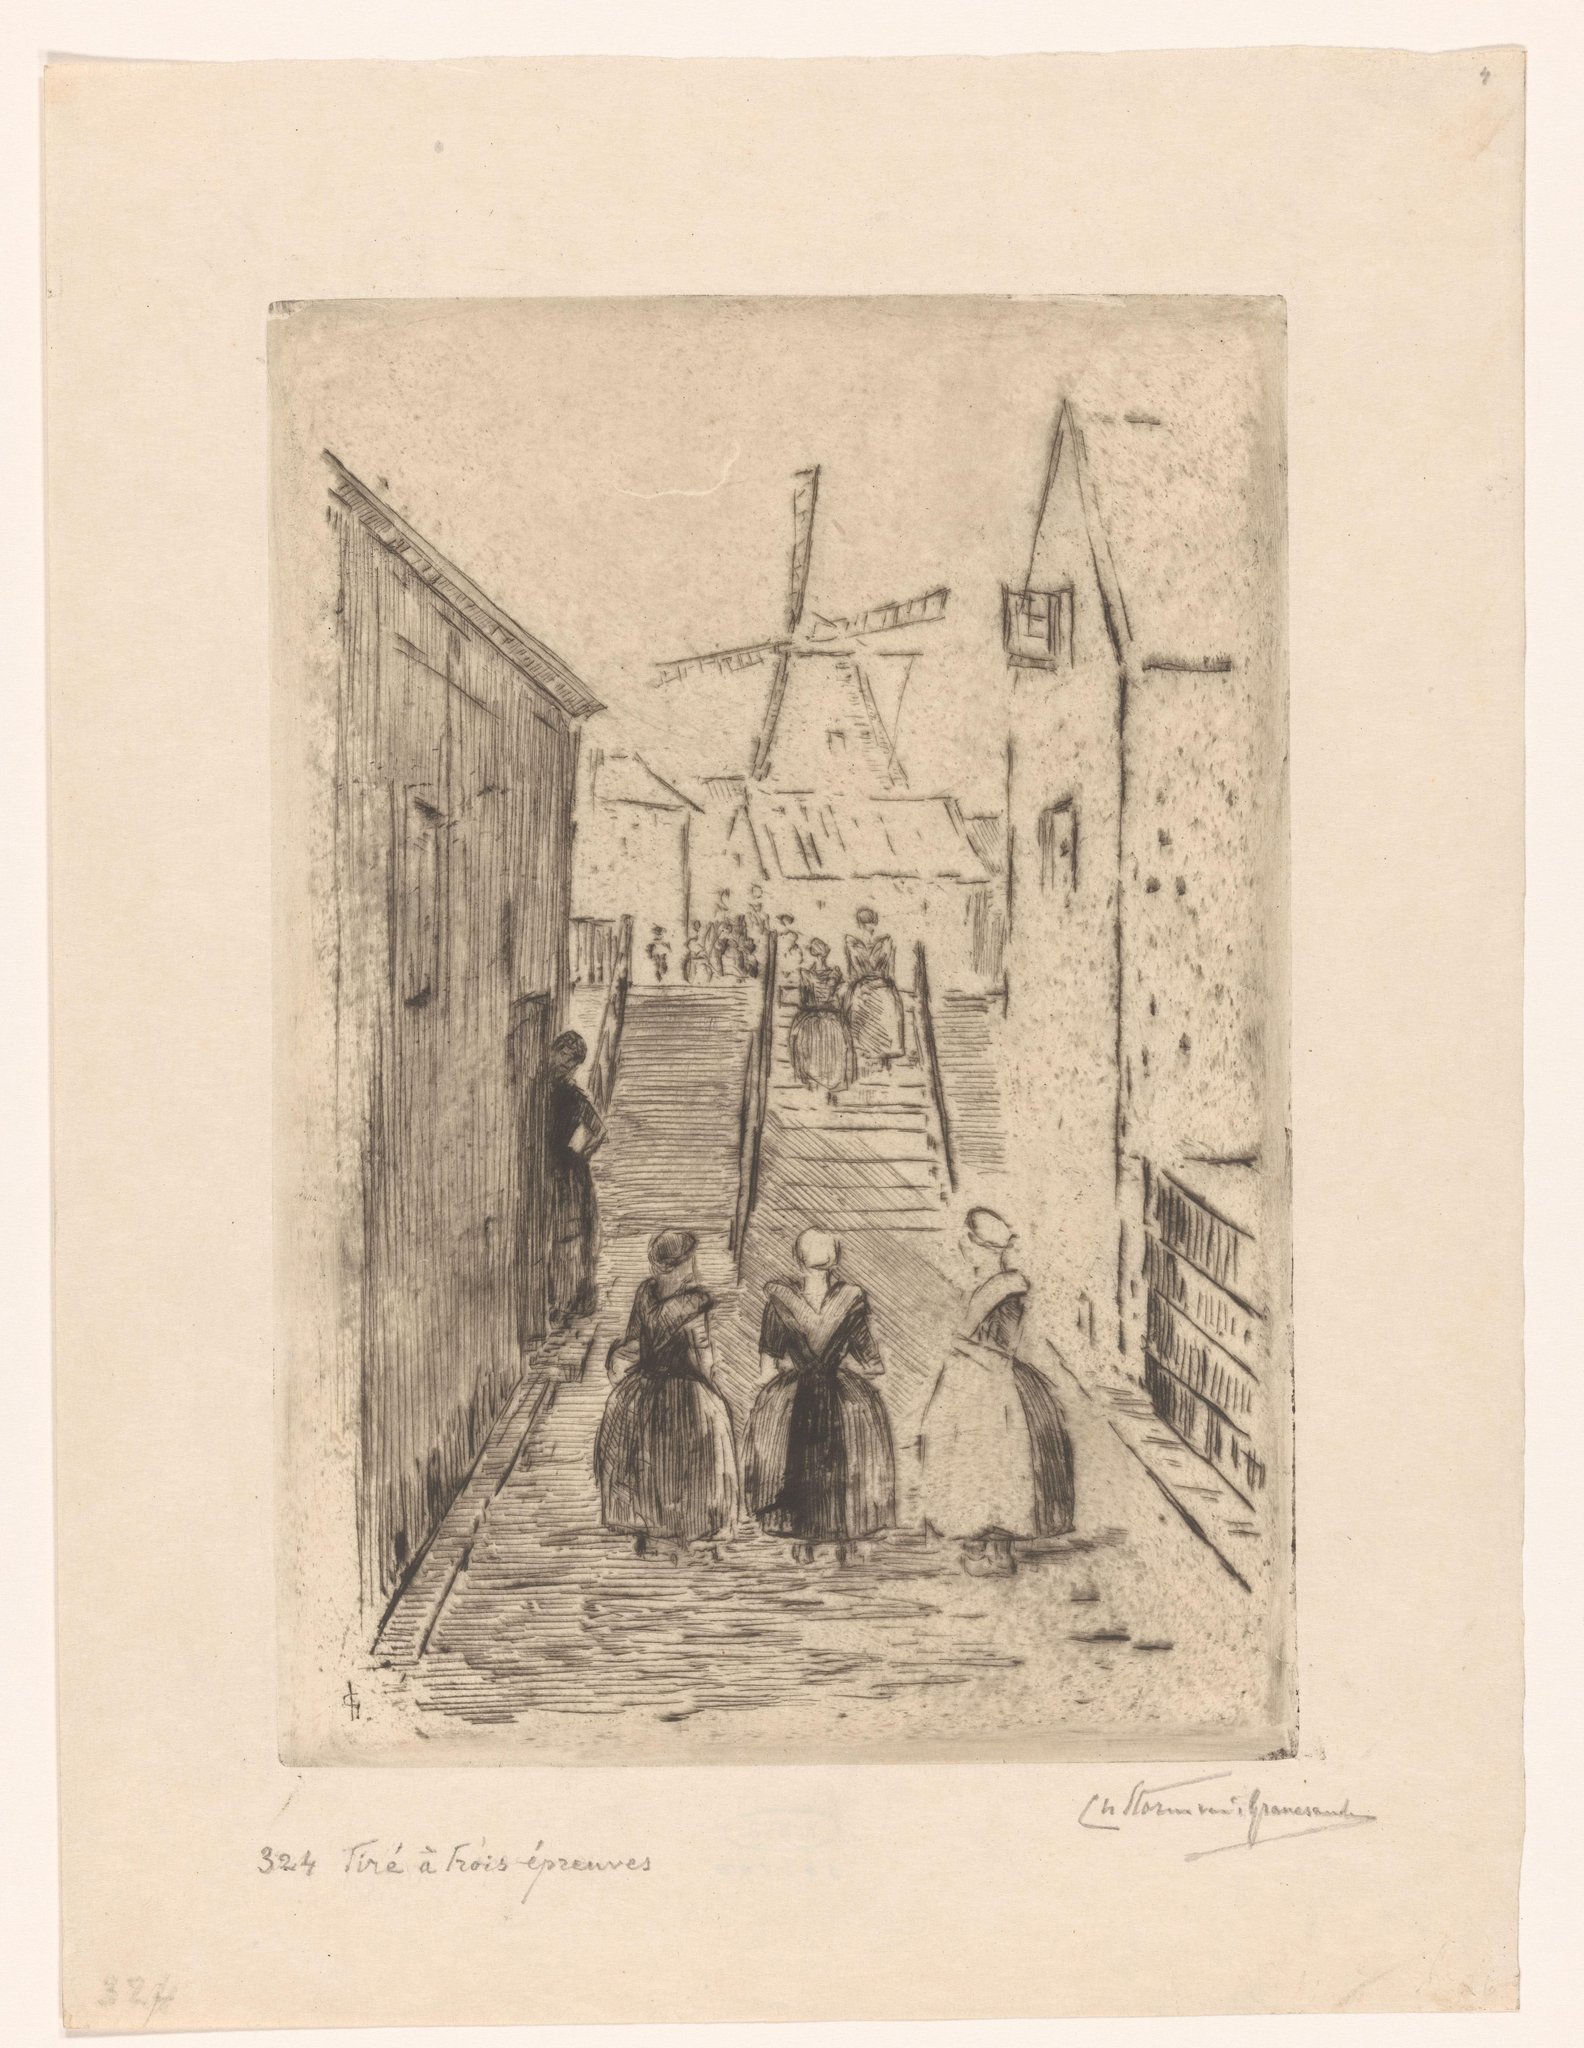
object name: print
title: Straatgezicht in Terneuzen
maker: carel nicolaas storm van s-gravesande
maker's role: draughtsman, print maker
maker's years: 1841-1924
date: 1889-1902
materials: paper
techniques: drypoint, intaglio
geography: netherlands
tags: sloping street; street with steps or stairs, folk costume, regional costume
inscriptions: collector's mark: Lugt 2228, inscription: ‘Tiré à trois épreuves’, number: ‘324’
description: Mogelijk vermeld in: Storm van 's-Gravesande, Charles. Catalogue des eaux-fortes et lithographies. New York: s.n., 1903, of in een onbekende latere uitgave van het manuscript. Vermoedelijk vermeld als catalogusnummer 324.